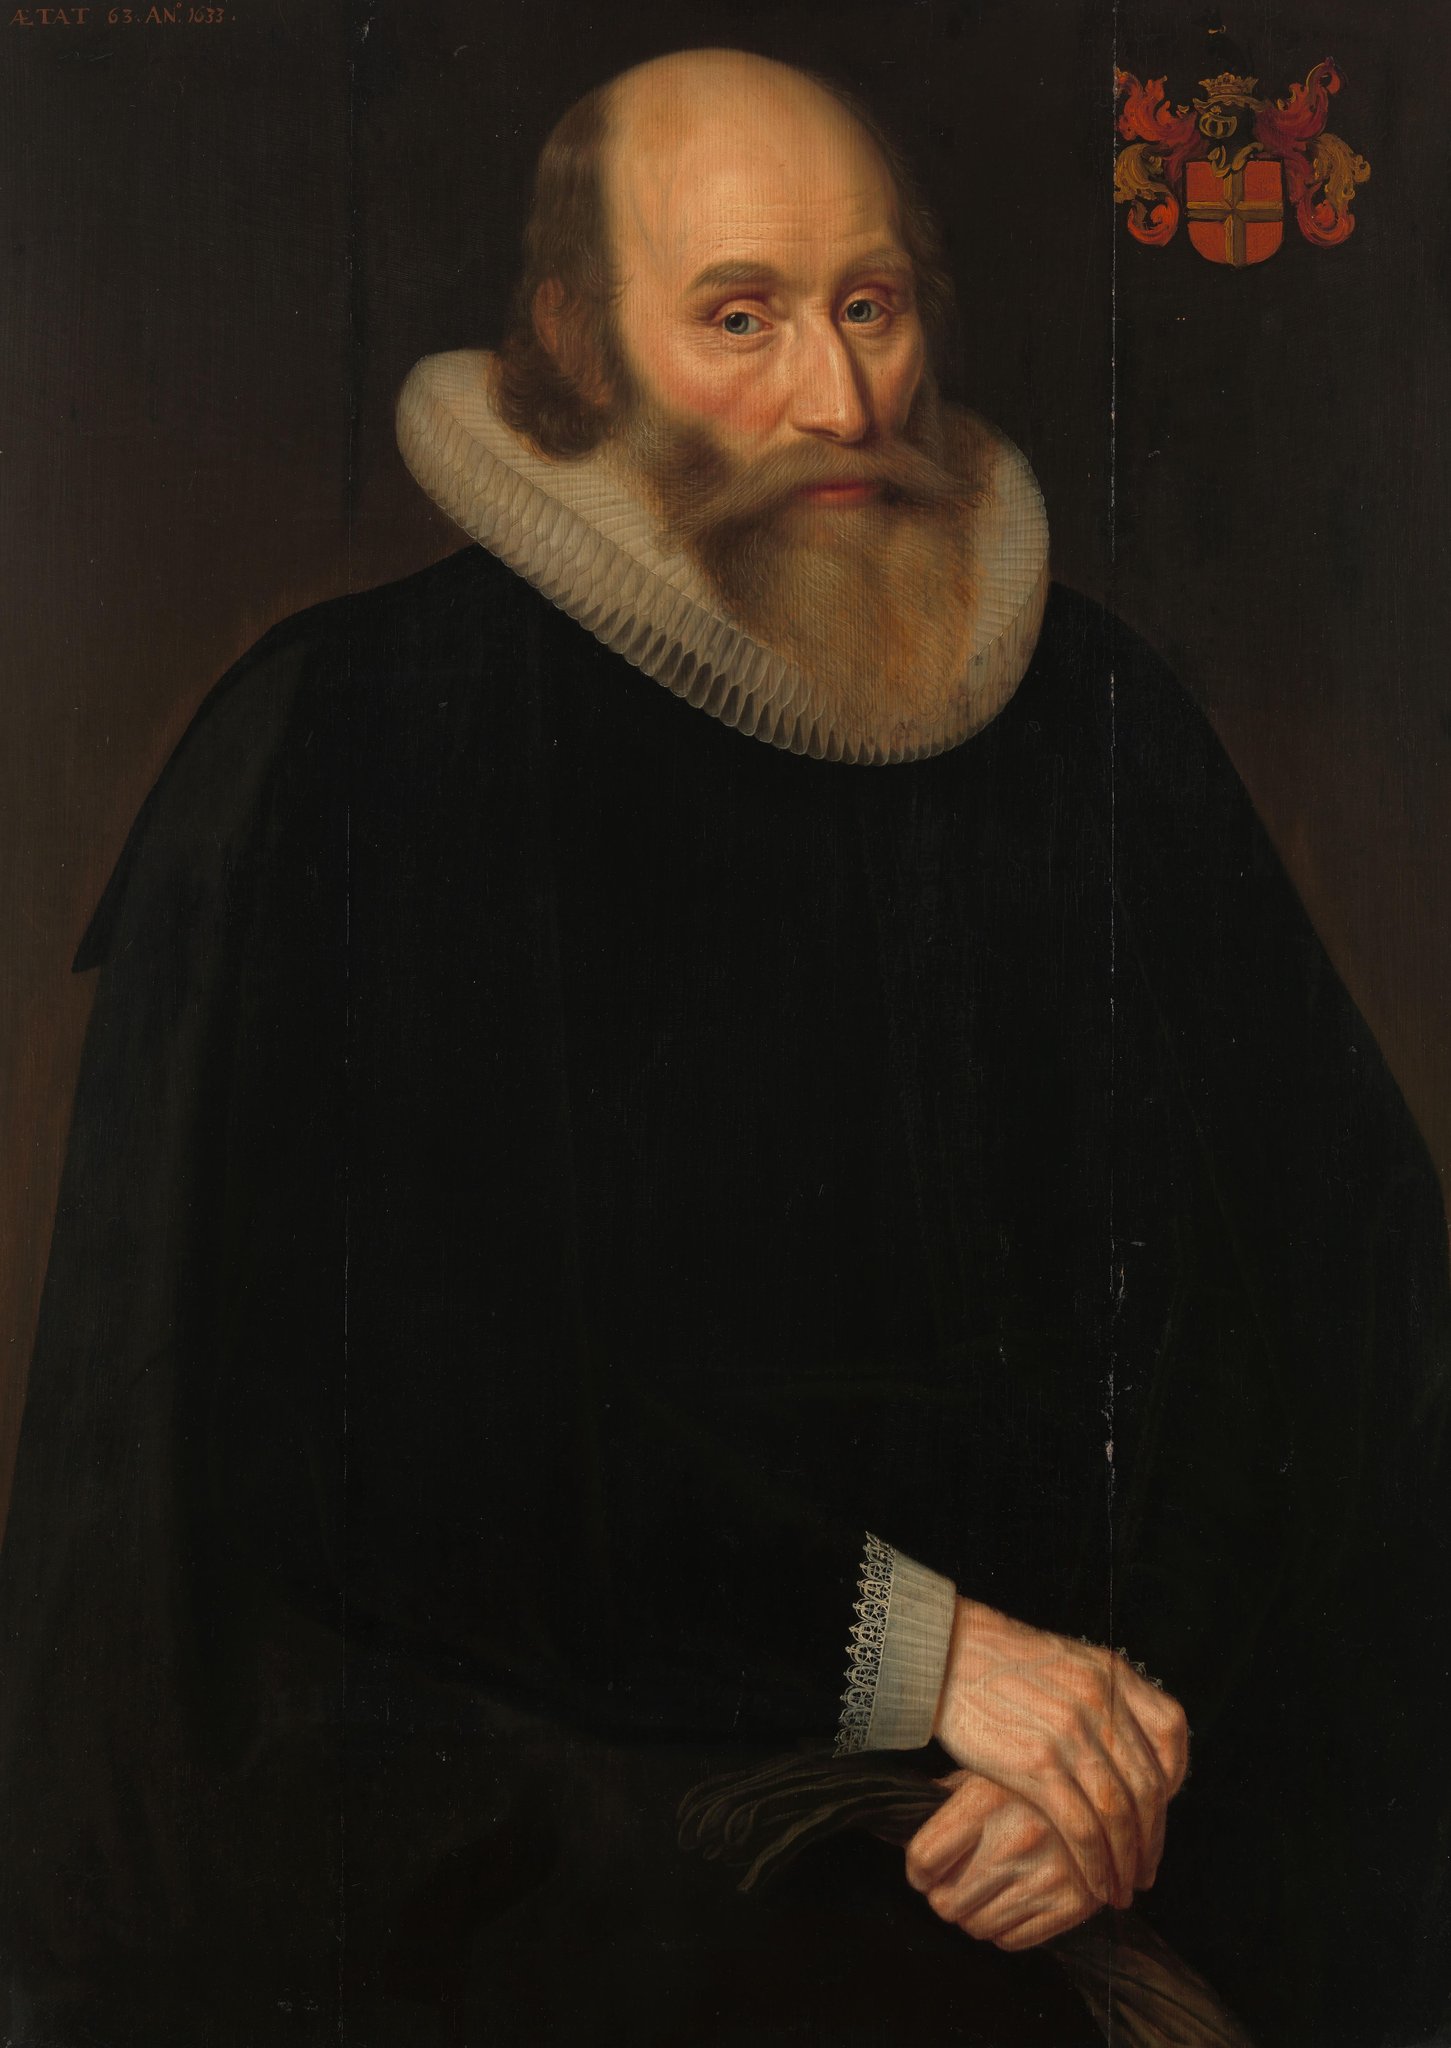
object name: painting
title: Portrait of Antonius Antonides van der Linden, Physician in Amsterdam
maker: hendrik meerman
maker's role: painter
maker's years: 1610-1650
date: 1633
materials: oil, panel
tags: historical persons, physician, doctor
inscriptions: inscription and date: ‘Morientis Imago AEtat 63 Anº 1633’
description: Portret van Antonius Antonides van der Linden, geneesheer te Amsterdam. Ten halven lijve, de handen gekruist voor de buik, handschoenen in de linkerhand. Rechtsboven het familiewapen. Pendant van SK-A-1544.